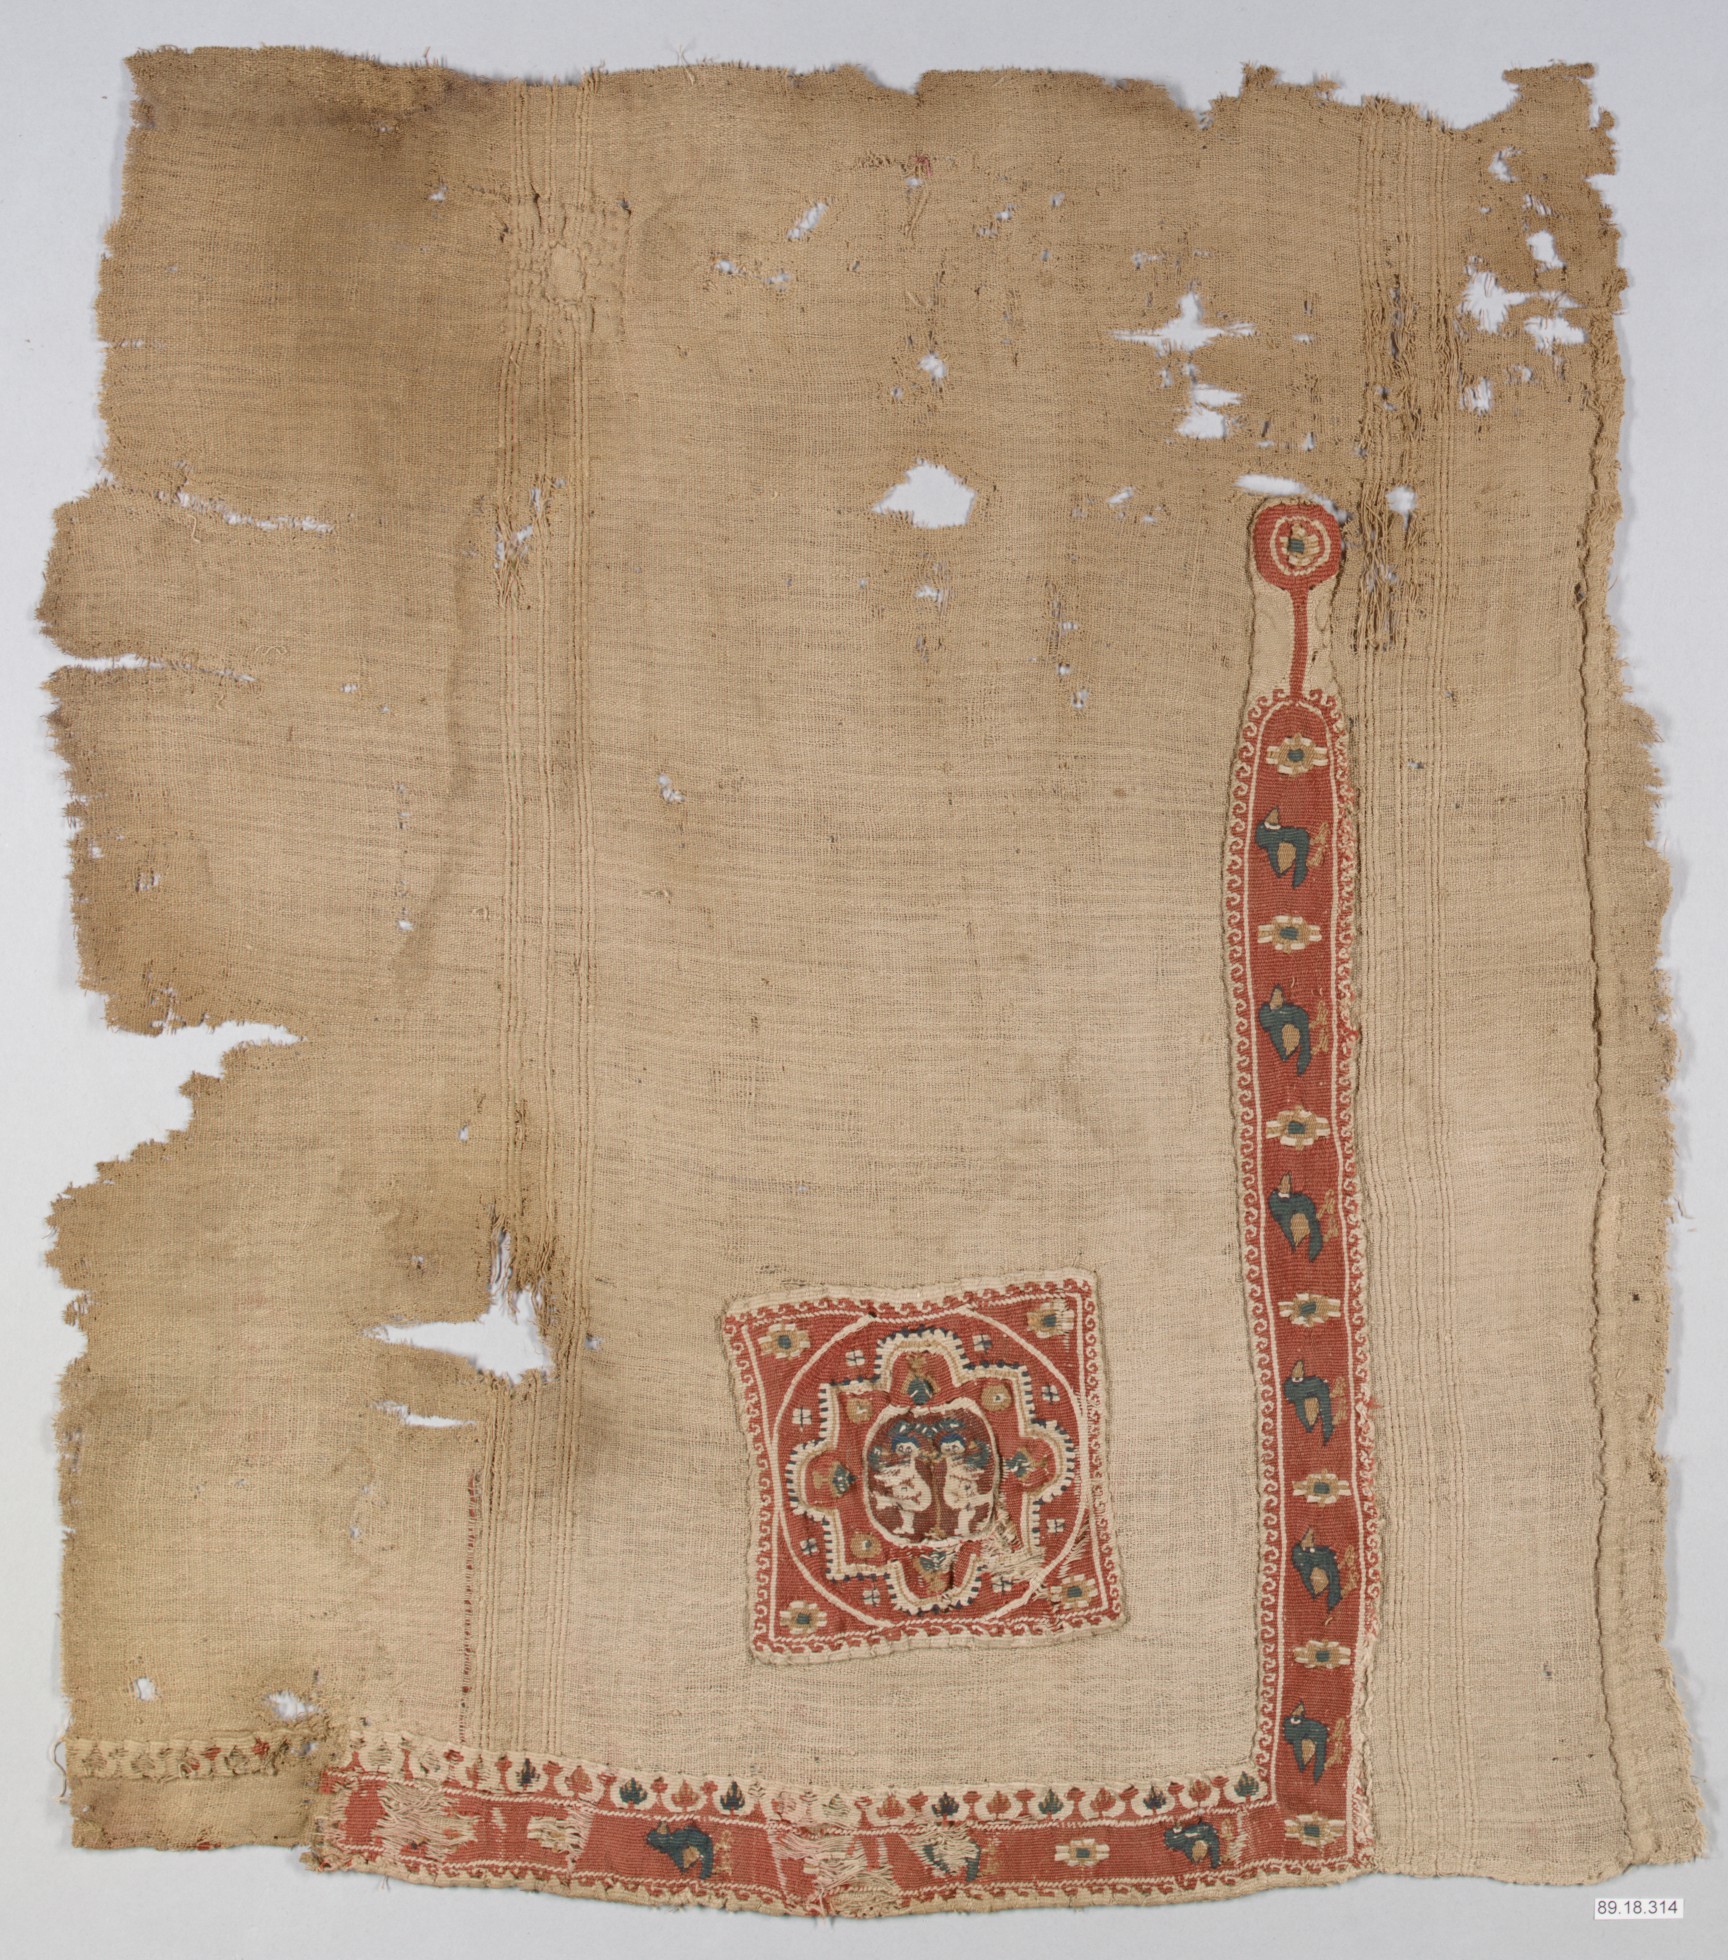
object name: textile fragment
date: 401-500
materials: linen, wool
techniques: weave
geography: egypt